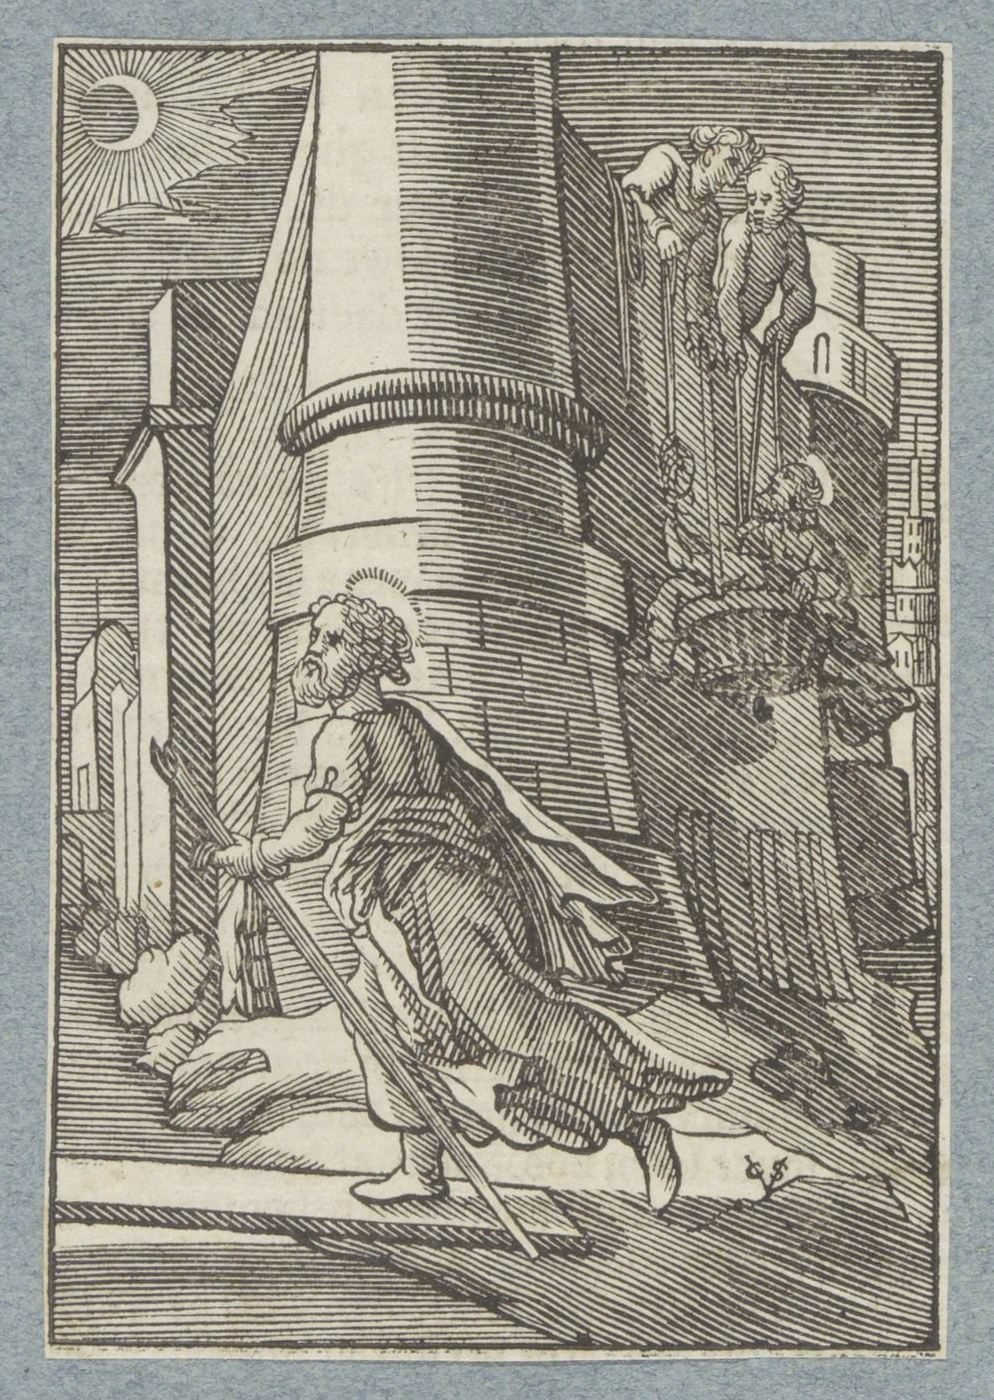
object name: album leaf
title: Paulus' vlucht uit Damascus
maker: pieter jacobsz. paets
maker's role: publisher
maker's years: 1587-1667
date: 1629-1646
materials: paper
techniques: letterpress printing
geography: amsterdam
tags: disciples let paul down the wall of the city in a basket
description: De prent is afkomstig uit een van de uitgaven van P.J. Paets uit Amsterdam. De prent wordt mogelijk al gebruikt in: Der Zielen Lust-hof. Leuven, I.Jacbosz voor P.J. Paets [= Amsterdam, P.J. Paets], 1629. Ze komt in ieder geval voor in: Het Nieuwe Testament ons Salichmaeckers Jesu Christi. Amsterdam, P.J. Paets, 1646. De voorstelling is gekopieerd naar een prent van Philips Galle naar Maarten van Heemskerck, onderdeel van de serie getiteld Acta Apostolorum.